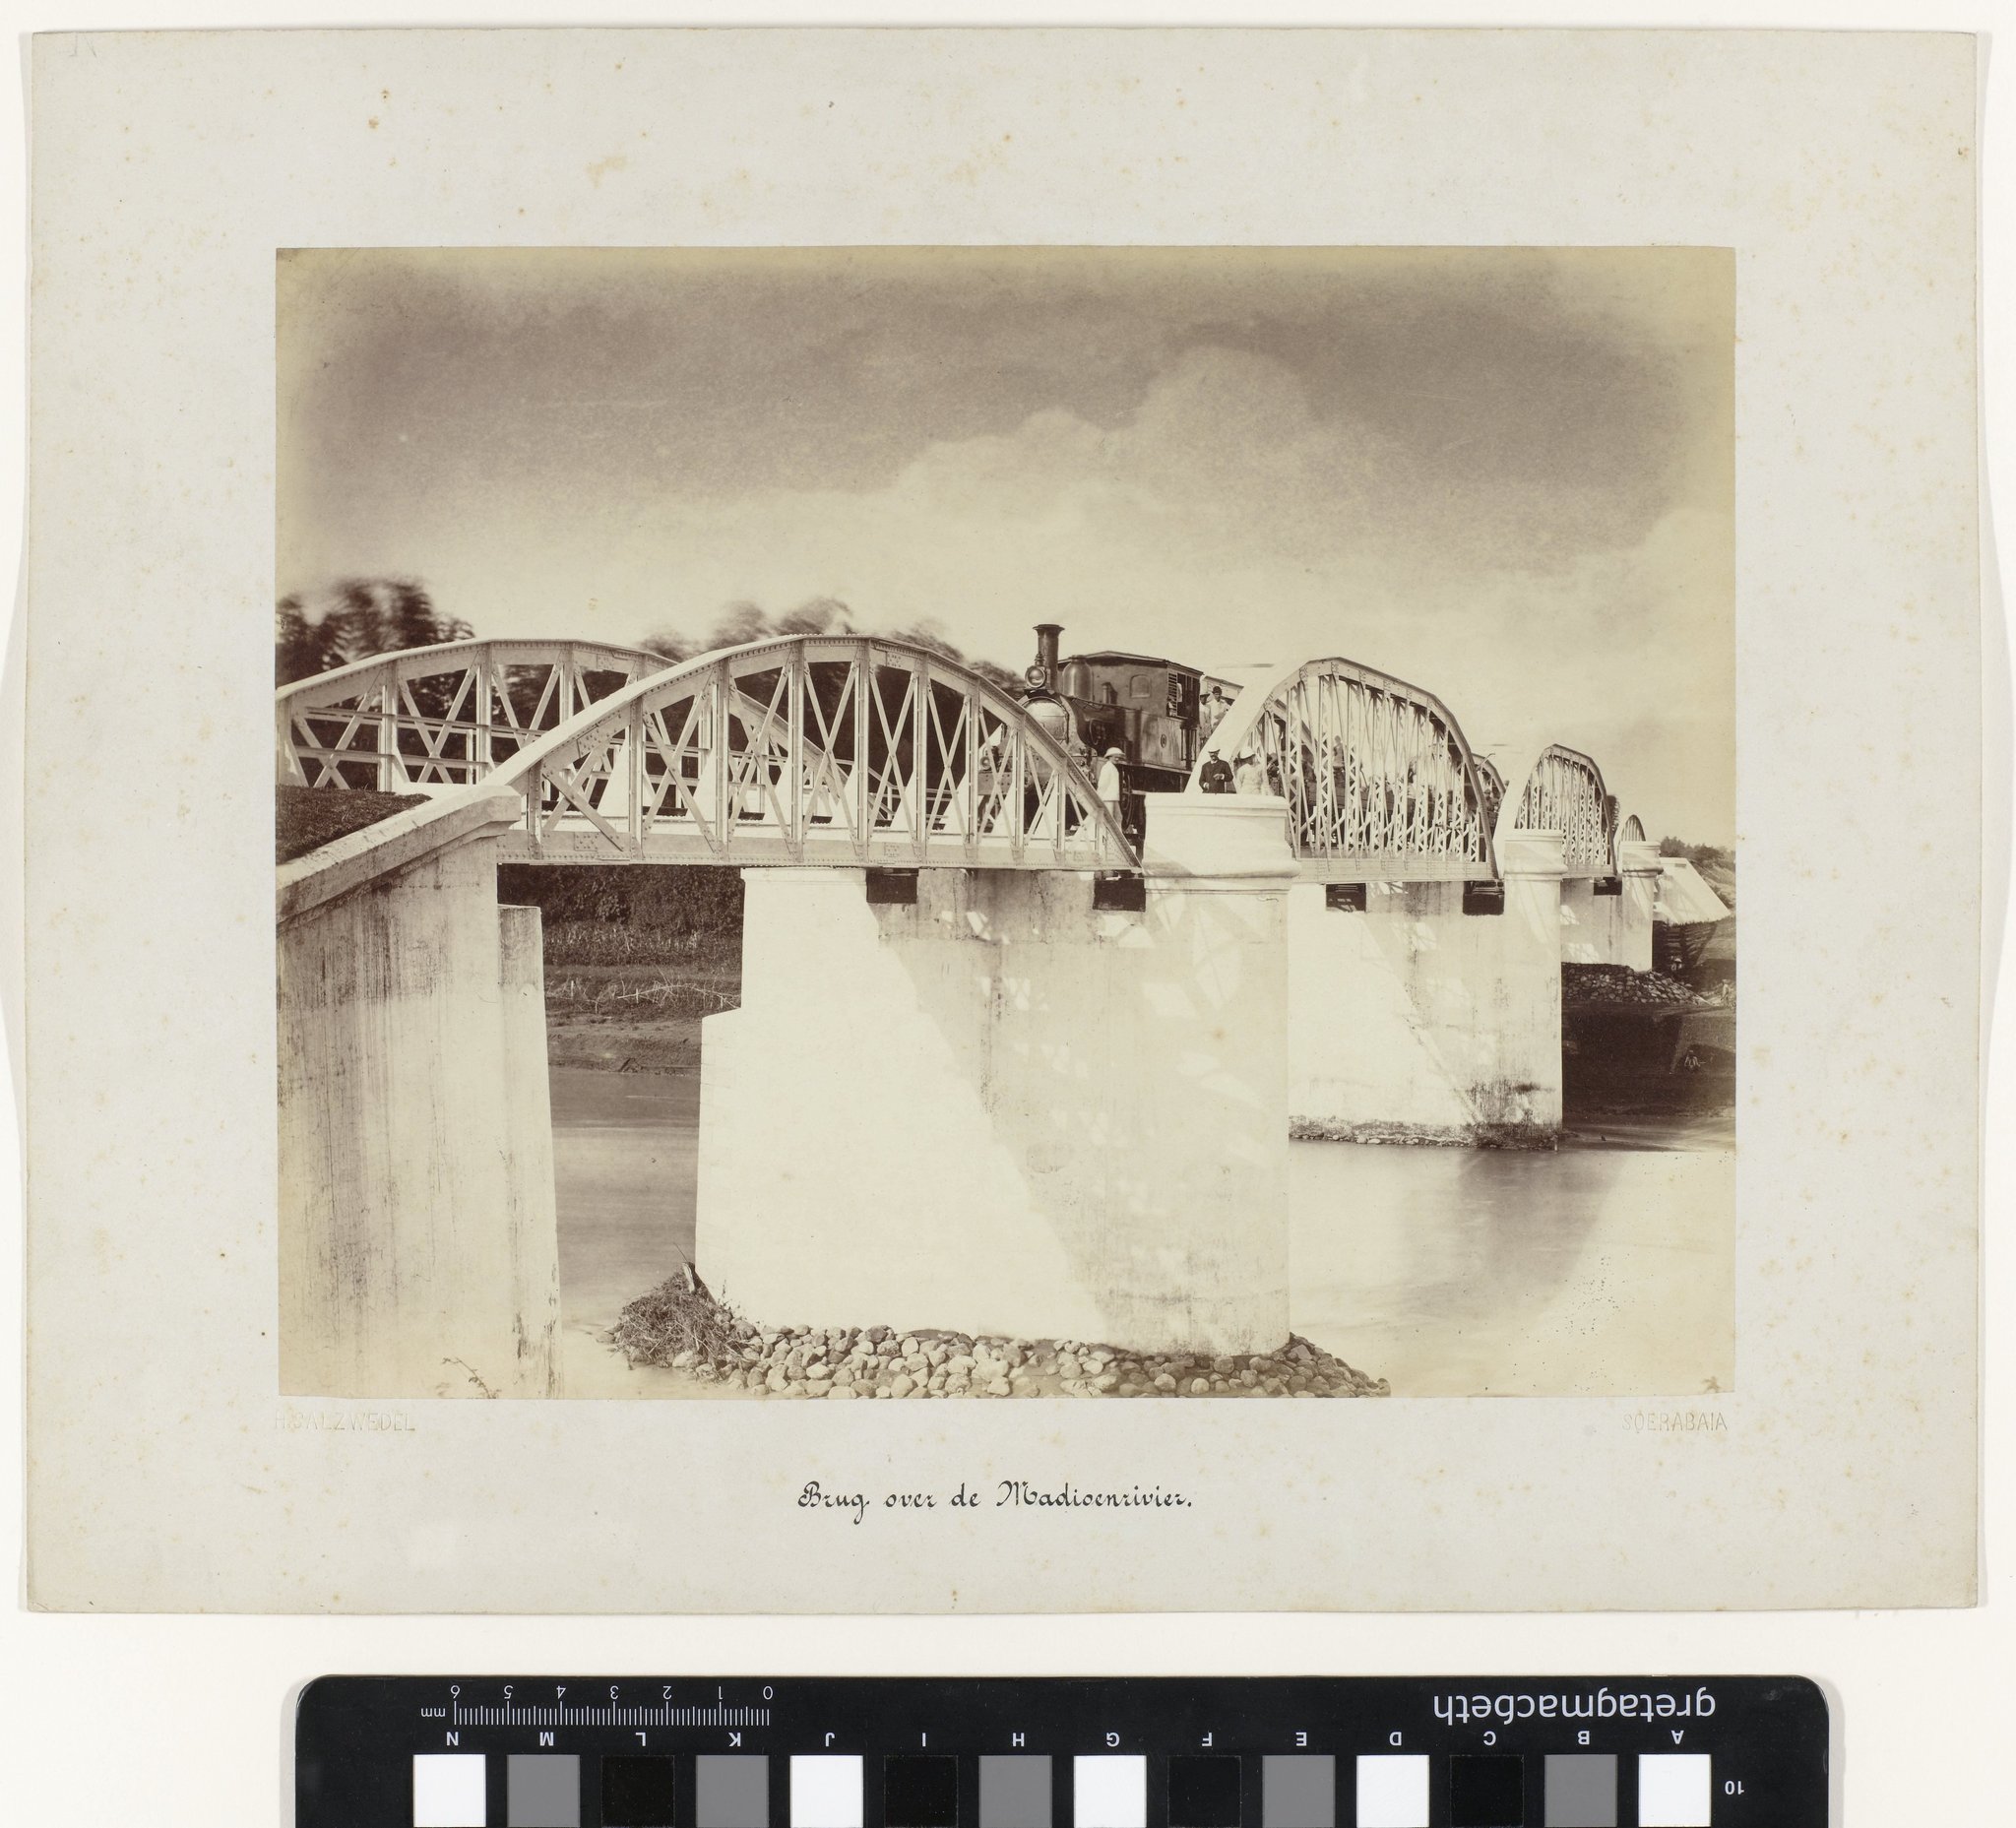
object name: photograph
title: Brug over Madioenrivier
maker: herman salzwedel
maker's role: fotograaf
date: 1880-1888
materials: photographic support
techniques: albumen print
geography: surabaya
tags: madiun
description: Spoorbrug over Madiun (Madioen) rivier, op de brug een trein en enkele staande mannen. Onderdeel van een groep van 62 foto's in een doos met het opschrift "Staatsspoorwegen op Java" uit 1888.